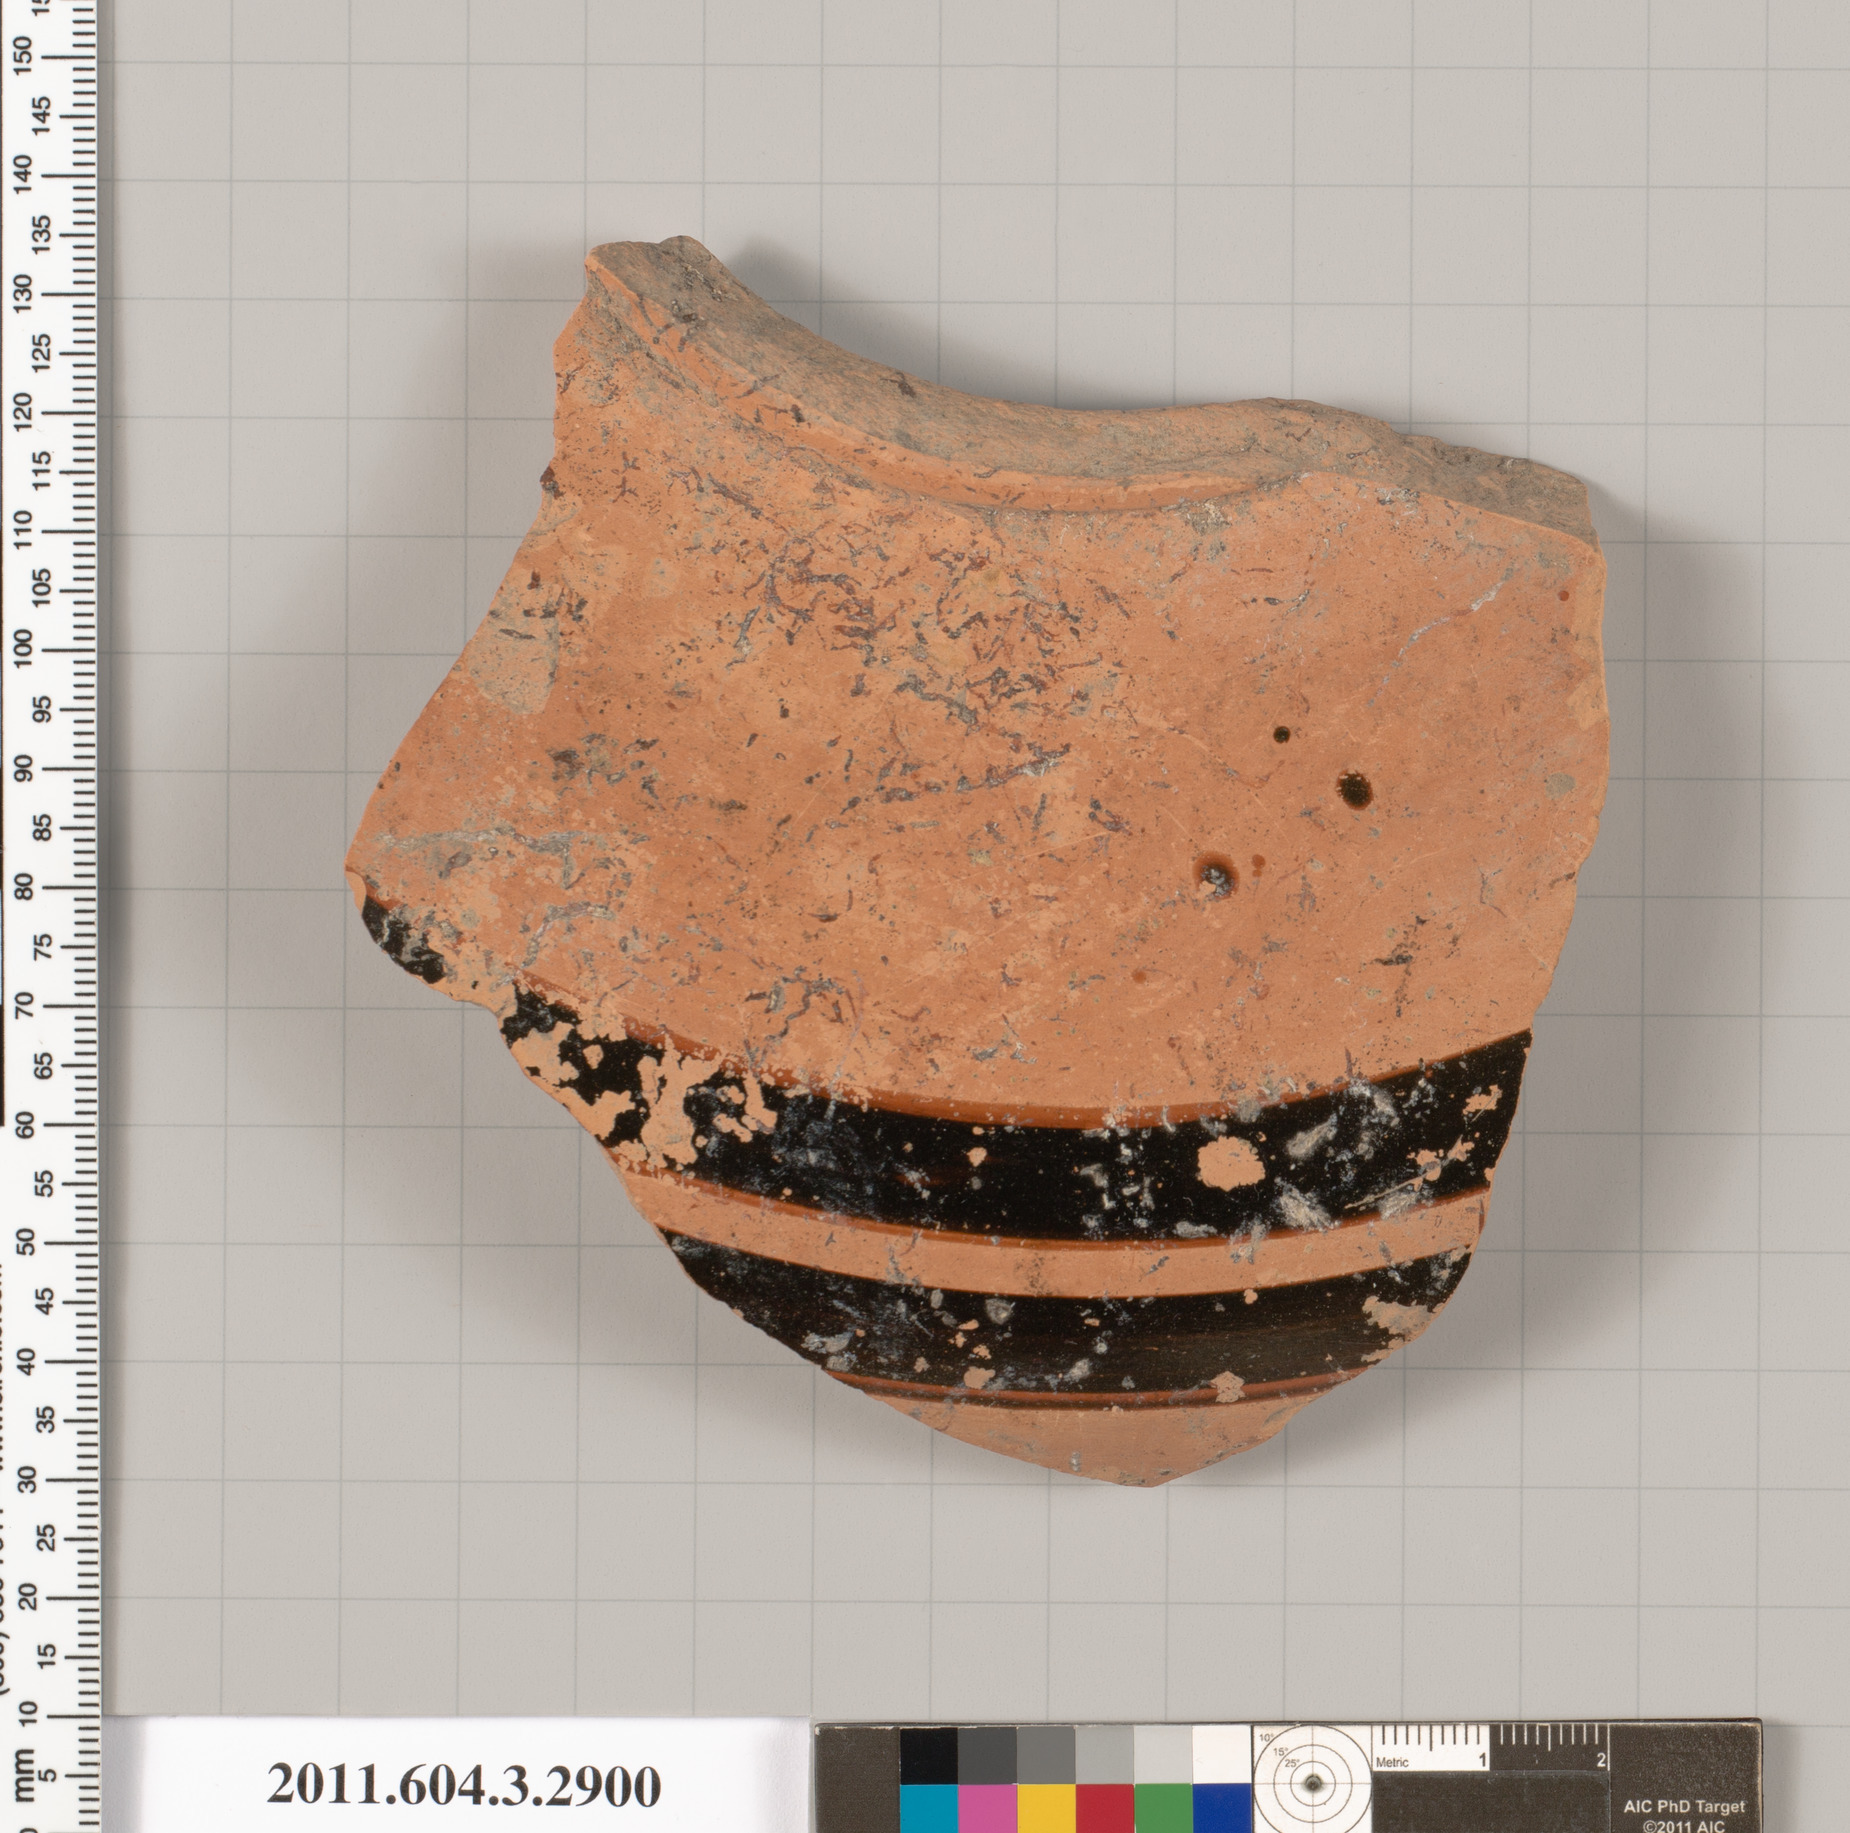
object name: oinochoe fragment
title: Terracotta fragment of an oinochoe (jug)?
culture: greek, attic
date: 480-450 BCE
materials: terracotta